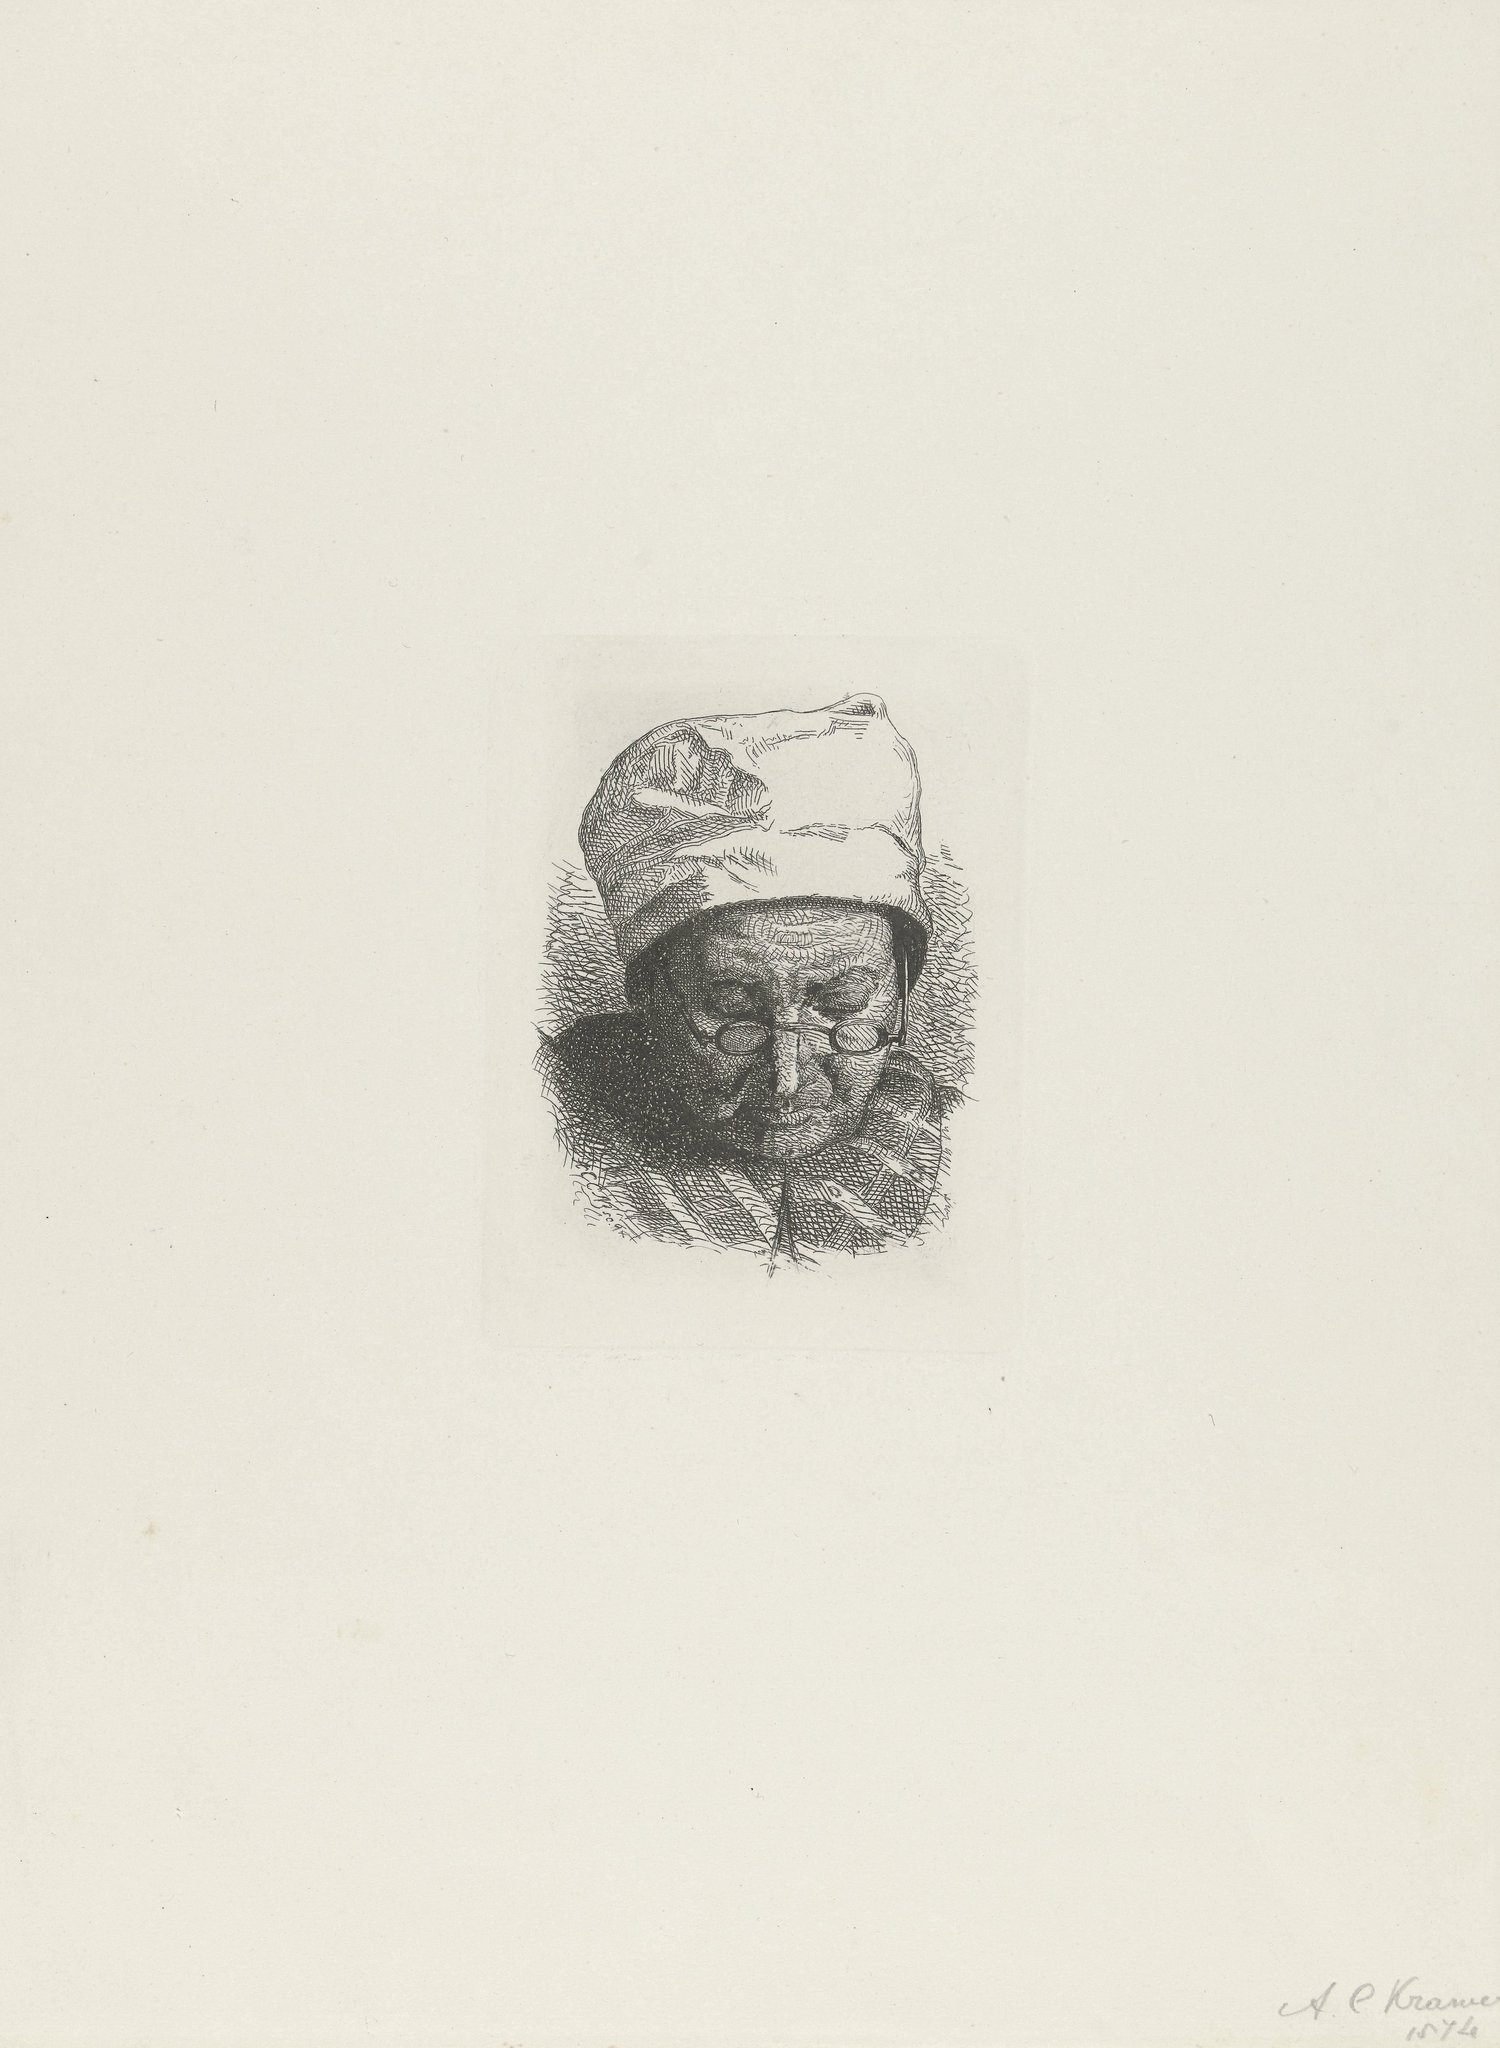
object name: print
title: Hoofd van een oude vrouw met bril en muts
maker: a.c. kramer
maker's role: print maker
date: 1874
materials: paper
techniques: etching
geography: netherlands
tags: eyeglasses, spectacles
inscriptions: collector's mark: Lugt 2228